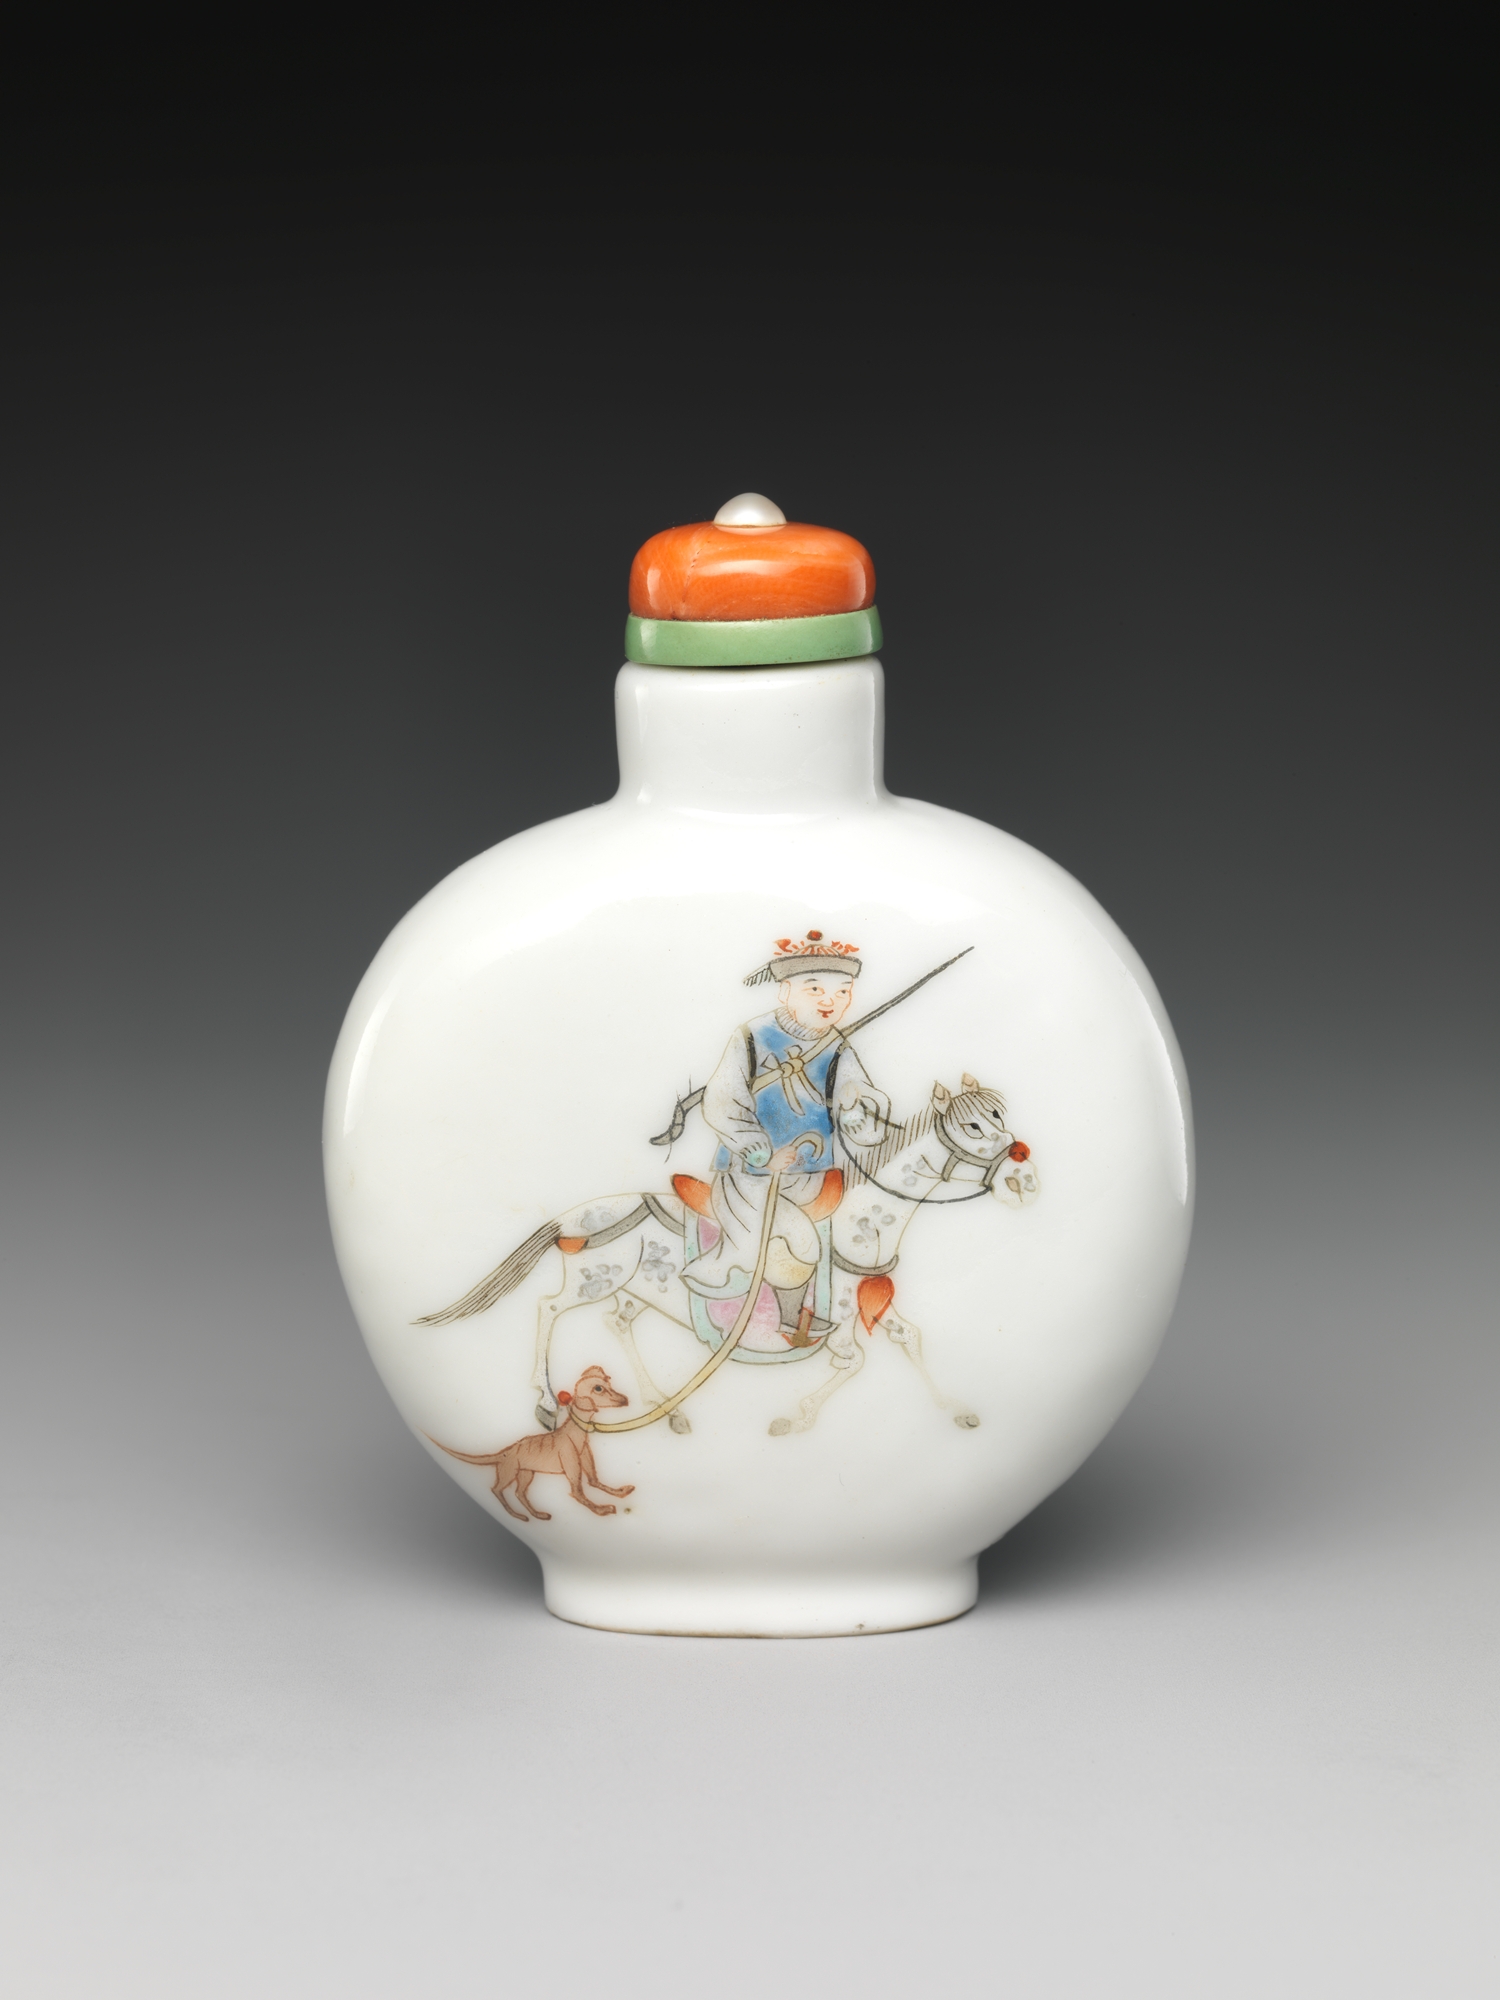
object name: snuff bottle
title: Snuff Bottle with Horse Rider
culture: chinese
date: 1821-1850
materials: coral, enamel, porcelain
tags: dogs,horses